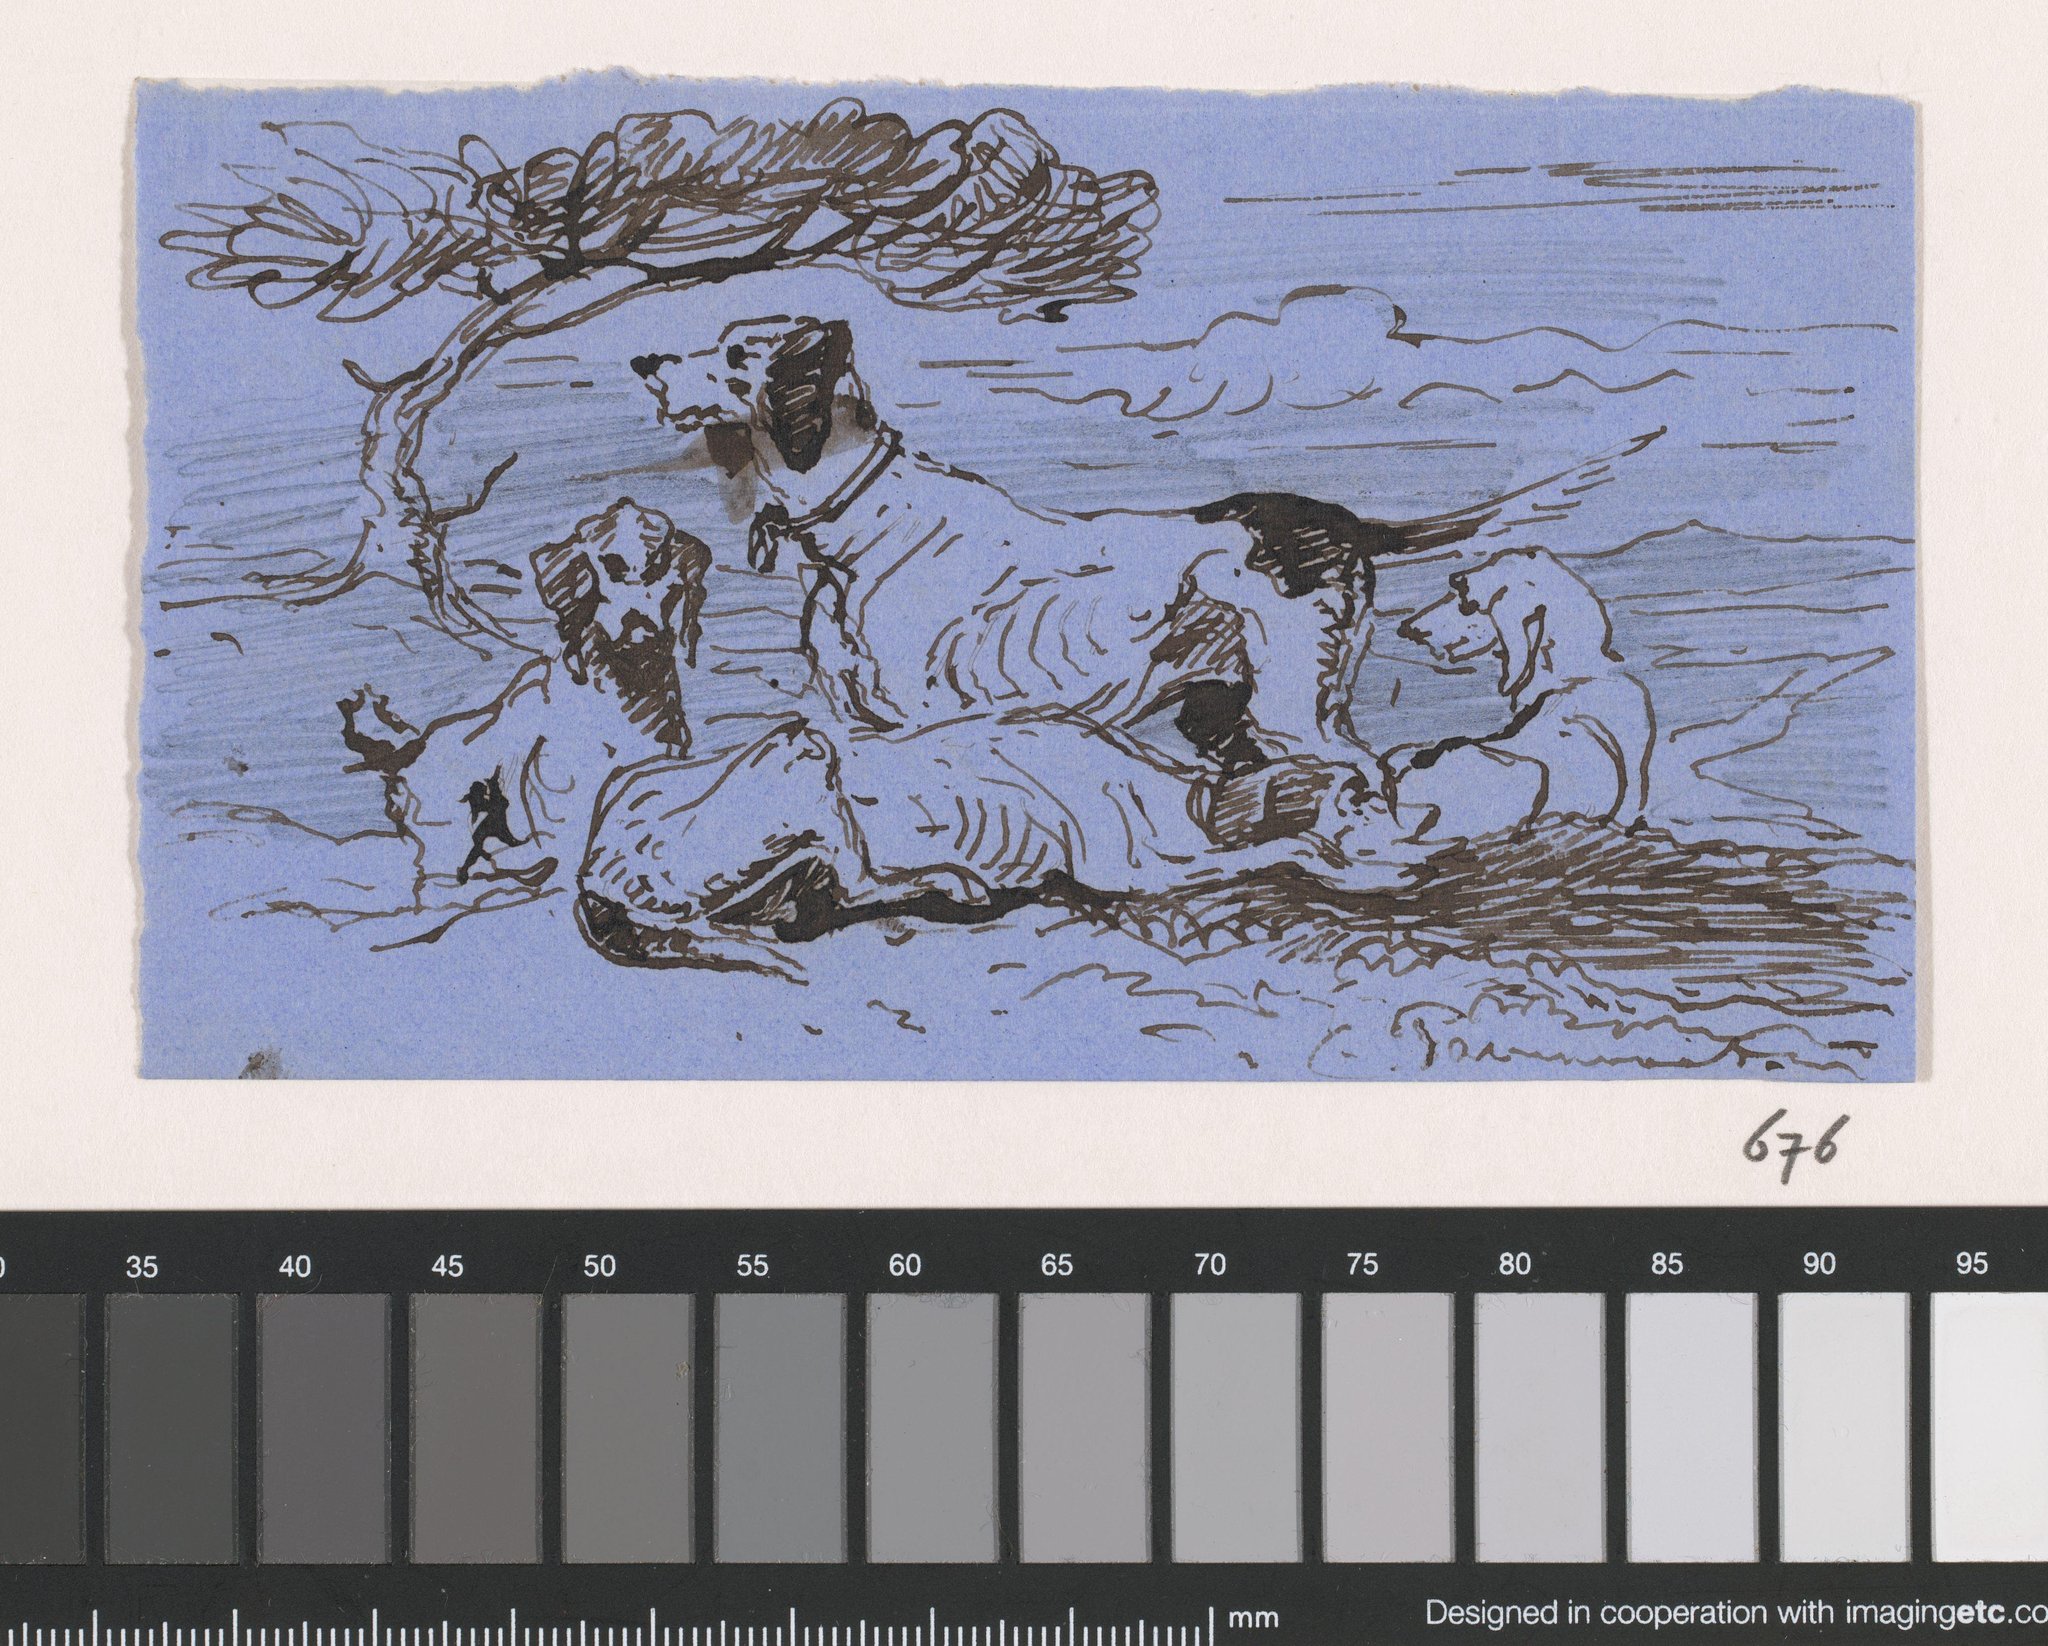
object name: drawing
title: Groep jachthonden rustend bij een boom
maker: johannes tavenraat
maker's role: draughtsman, painter, print maker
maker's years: 1809-1881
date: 1868-1880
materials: ink, paper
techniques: pen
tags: hunting dogs, hunters resting during the hunt, dog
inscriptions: collector's mark: Lugt 2228, signature: ‘Tavenraat’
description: Groep jachthonden rustend bij een boom. Op de achterzijde een handgeschreven lijstje met prijzen van schilderijen tussen 1837 en 1868.